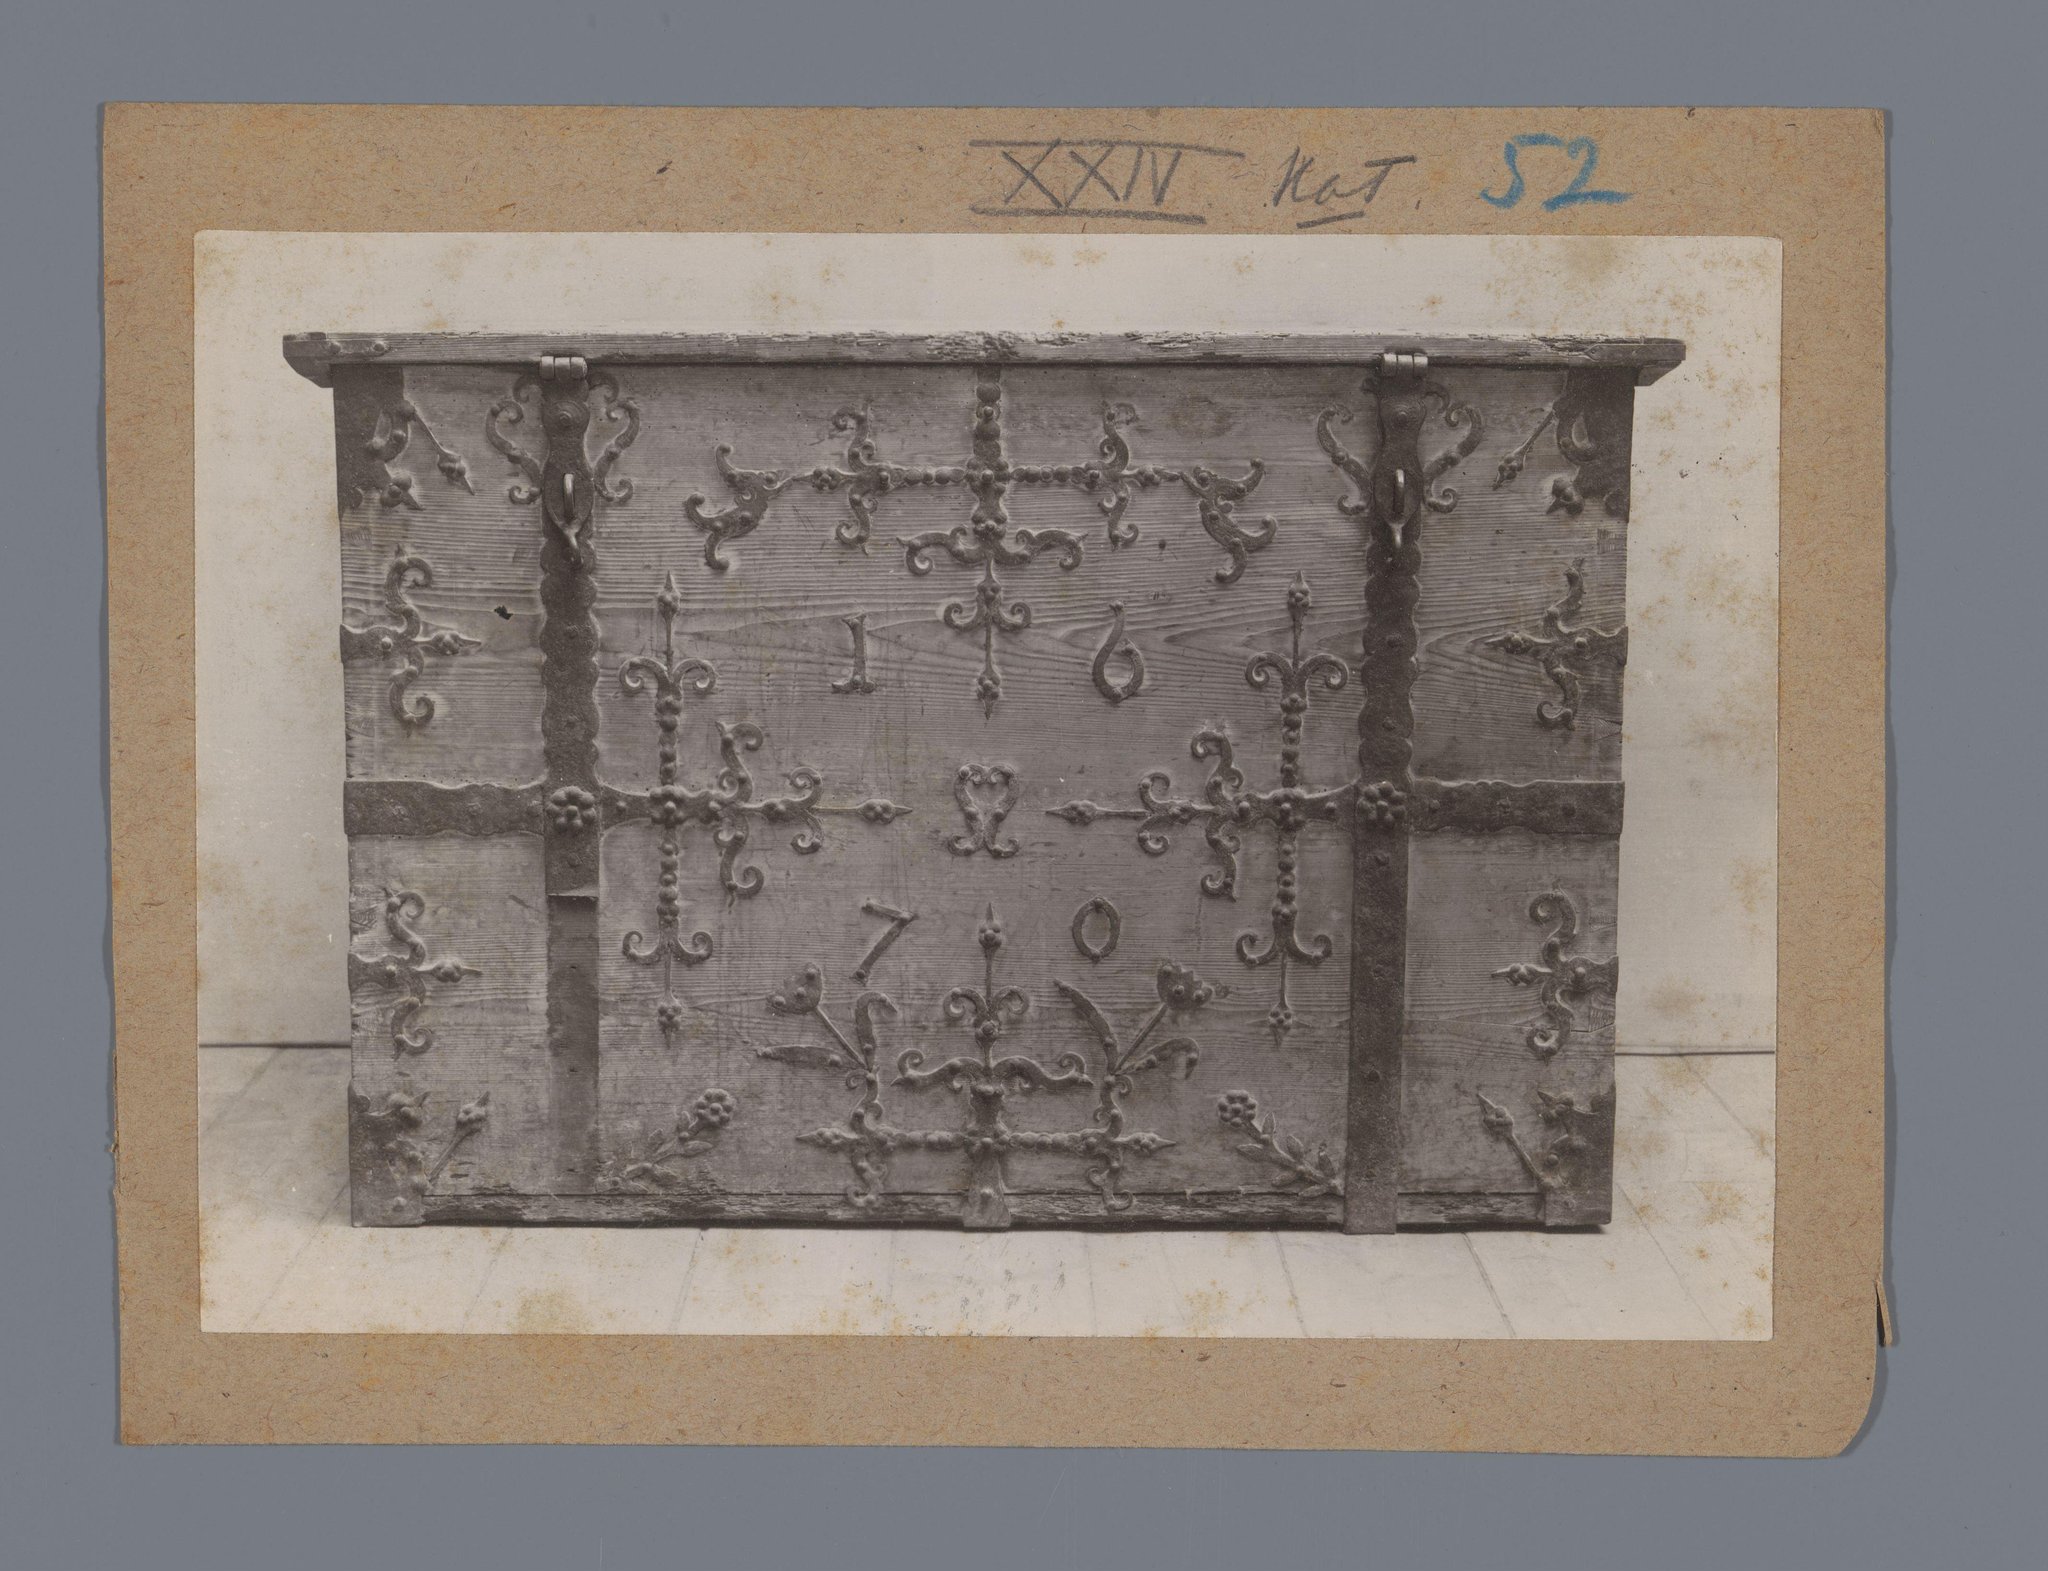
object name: photograph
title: Kist gedecoreerd met bloemen en het jaartal 1670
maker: Anonymous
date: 1875-1900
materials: photographic support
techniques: matte daylight collodion silver print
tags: chest, coffer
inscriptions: collector's mark: ‘Kunstnijverheidschool Quellinus Amsterdam Frans Halsstraat 14.’, number: ‘XXIV Kat 52’, collector's mark: ‘Instituut voor kunst-nijverheidsonderwijs Gabriël Metsustraat No. 16, Amsterdam’